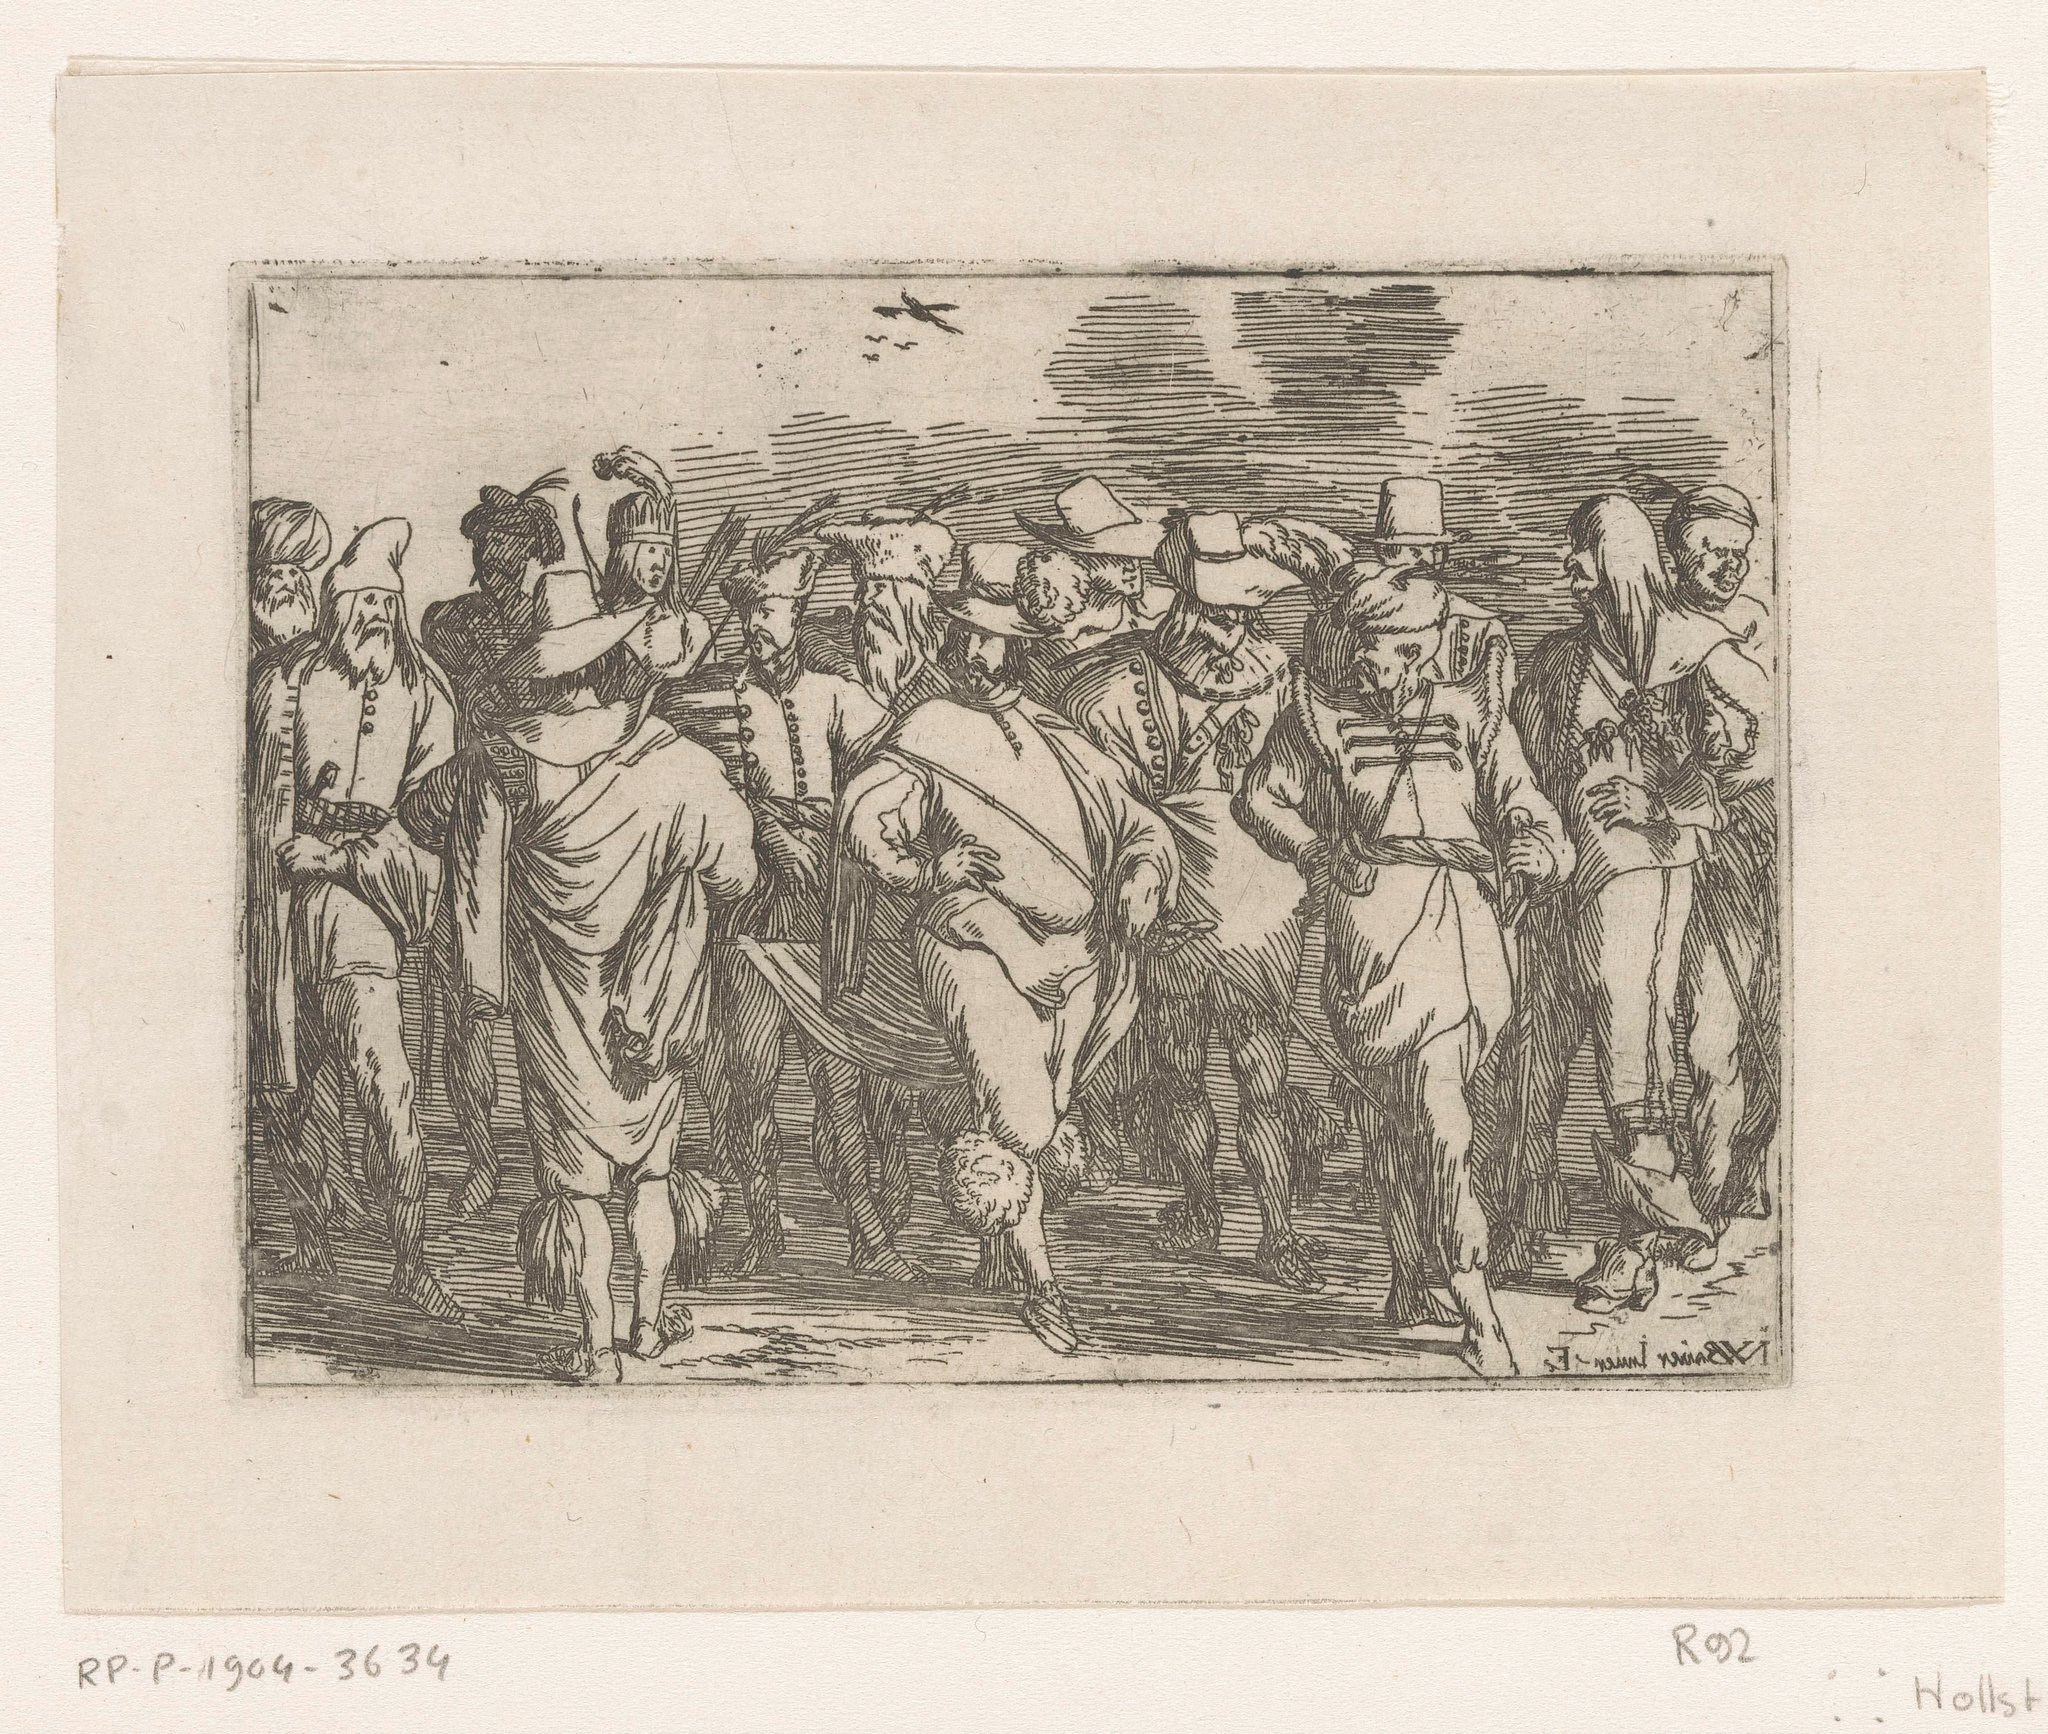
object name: print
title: Klederdrachten van verschillende volkeren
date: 1636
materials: paper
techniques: etching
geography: rome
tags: clothes, costume (+ men's clothes)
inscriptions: collector's mark: ‘N. Guerain (?)’, collector's mark: Lugt 2228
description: Vijftiende prent uit de serie 'Klederdrachten van verschillende volkeren', bestaand uit vijftien prenten en een titelprent.